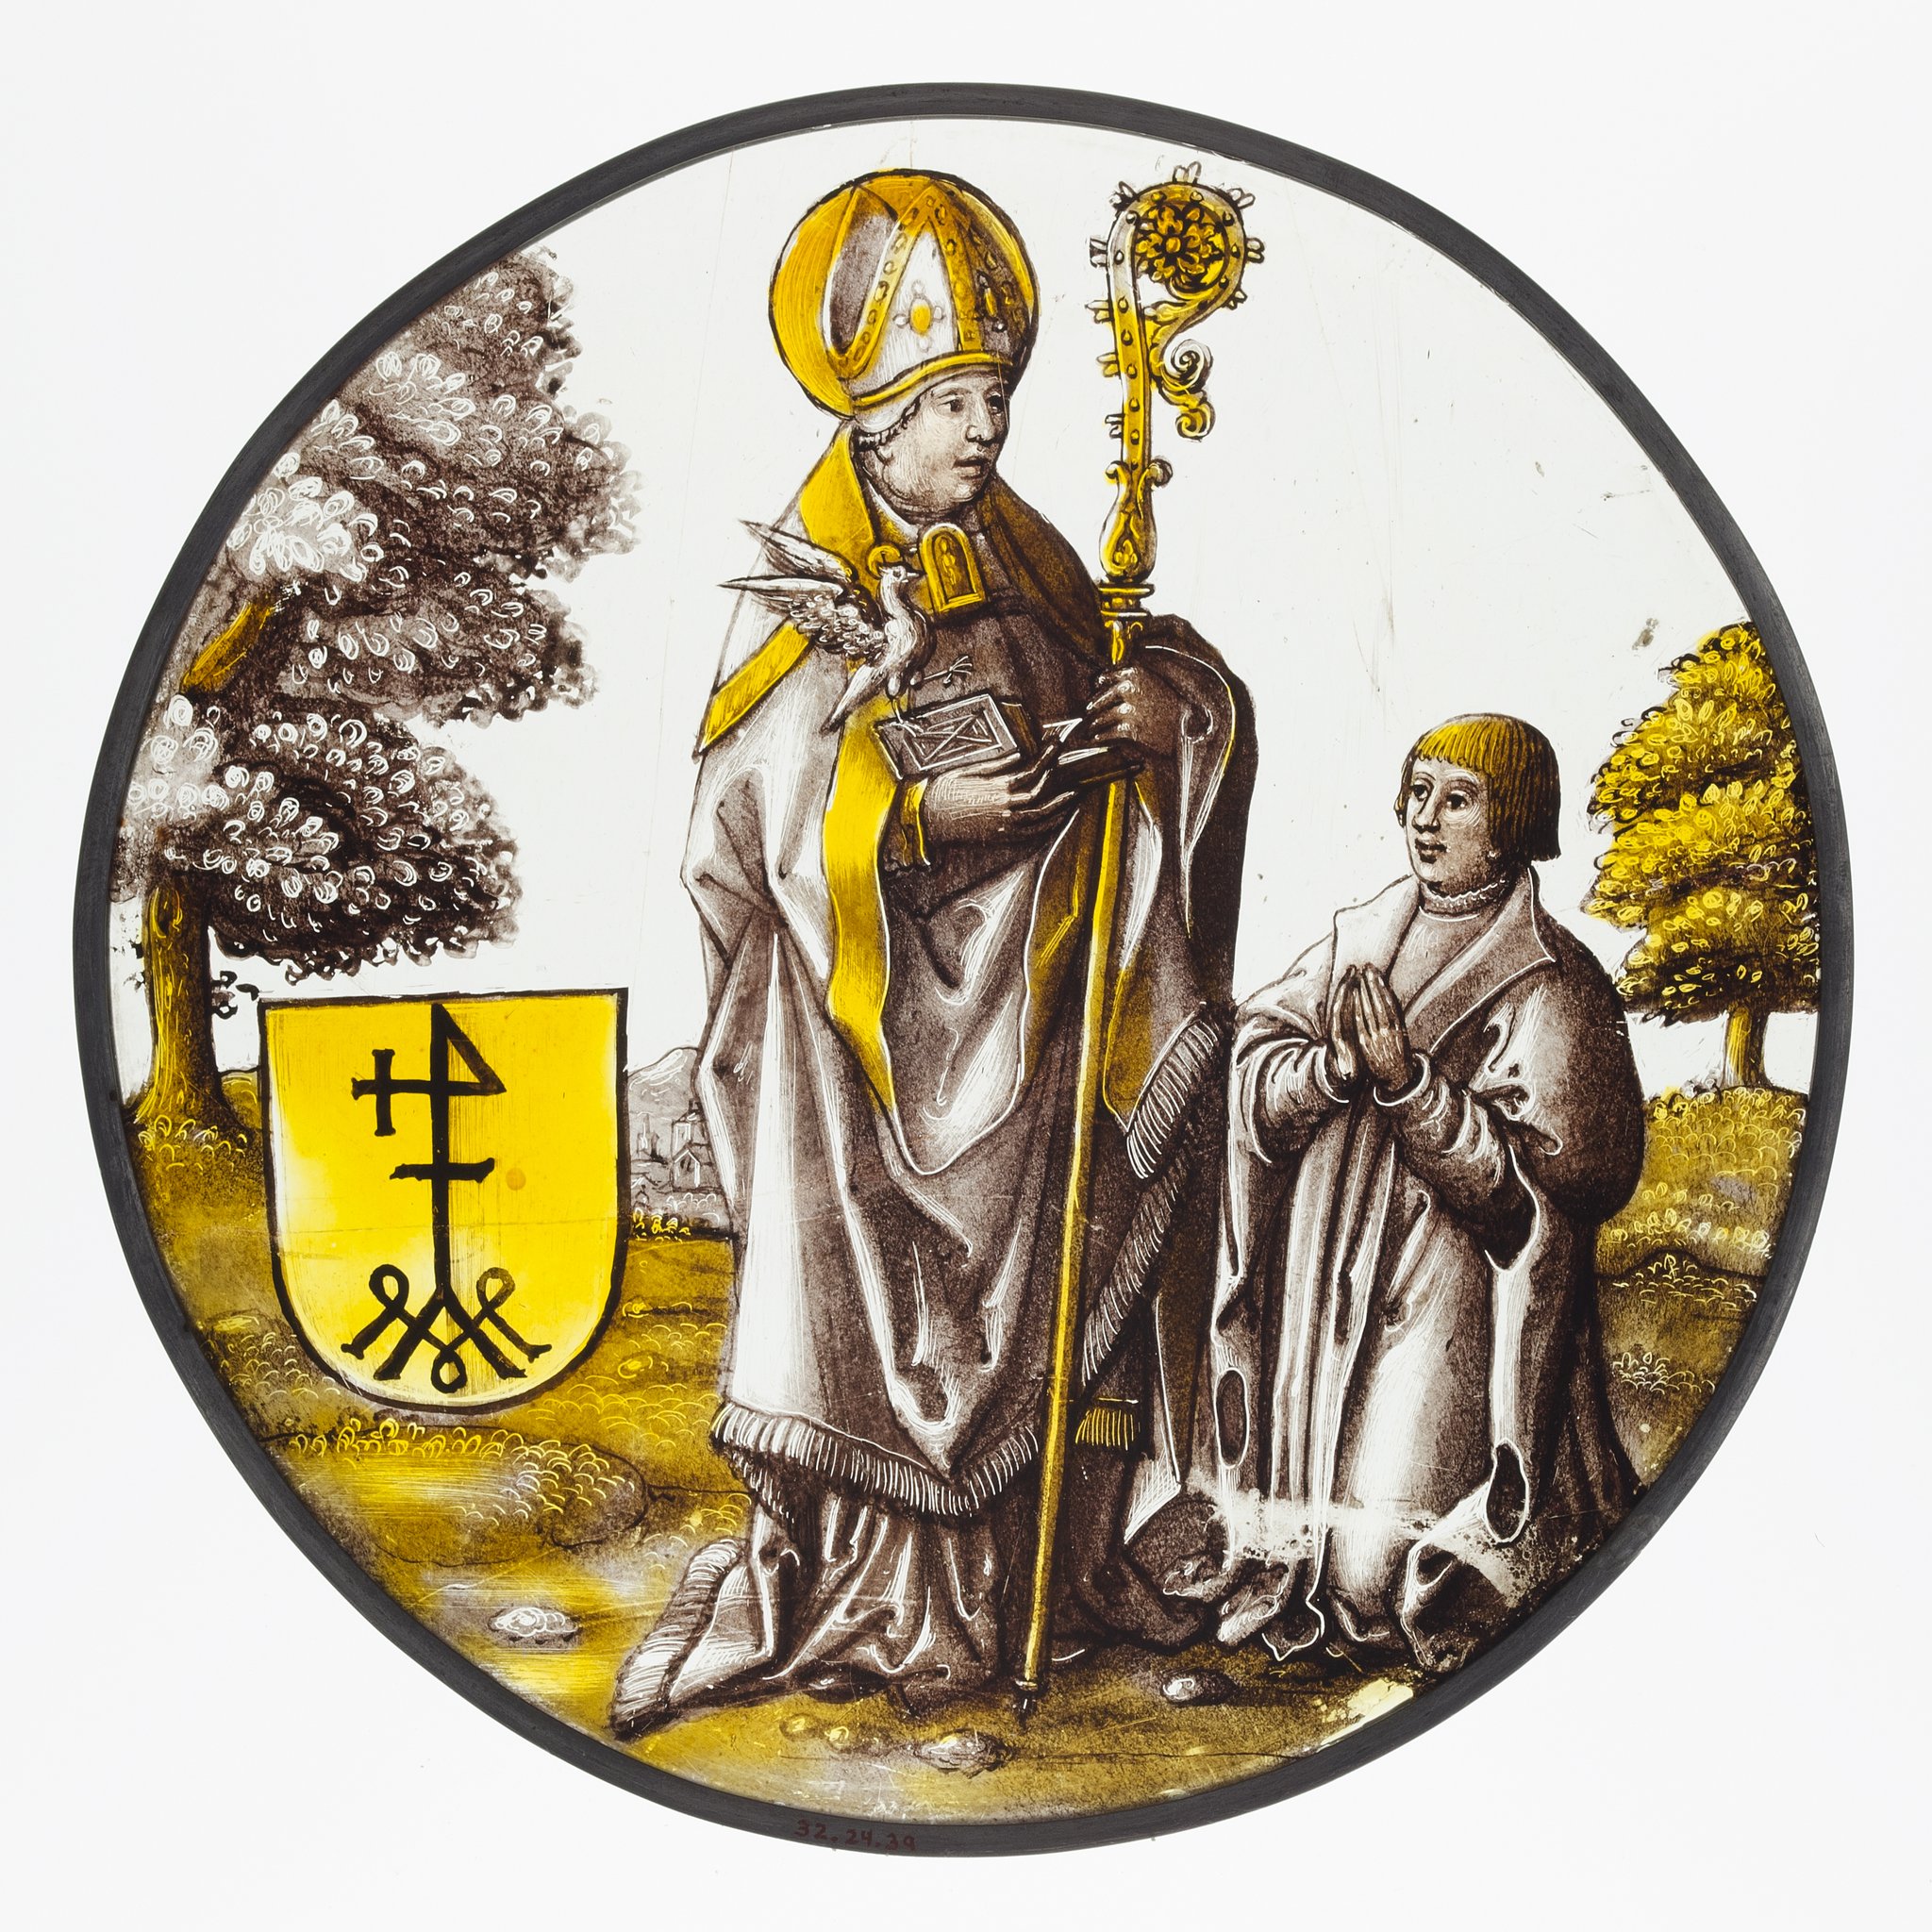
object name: roundel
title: Roundel with Saint Basil the Great with a Donor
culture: south netherlandish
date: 1515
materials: glass, paint, pigment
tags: men,croziers,saints